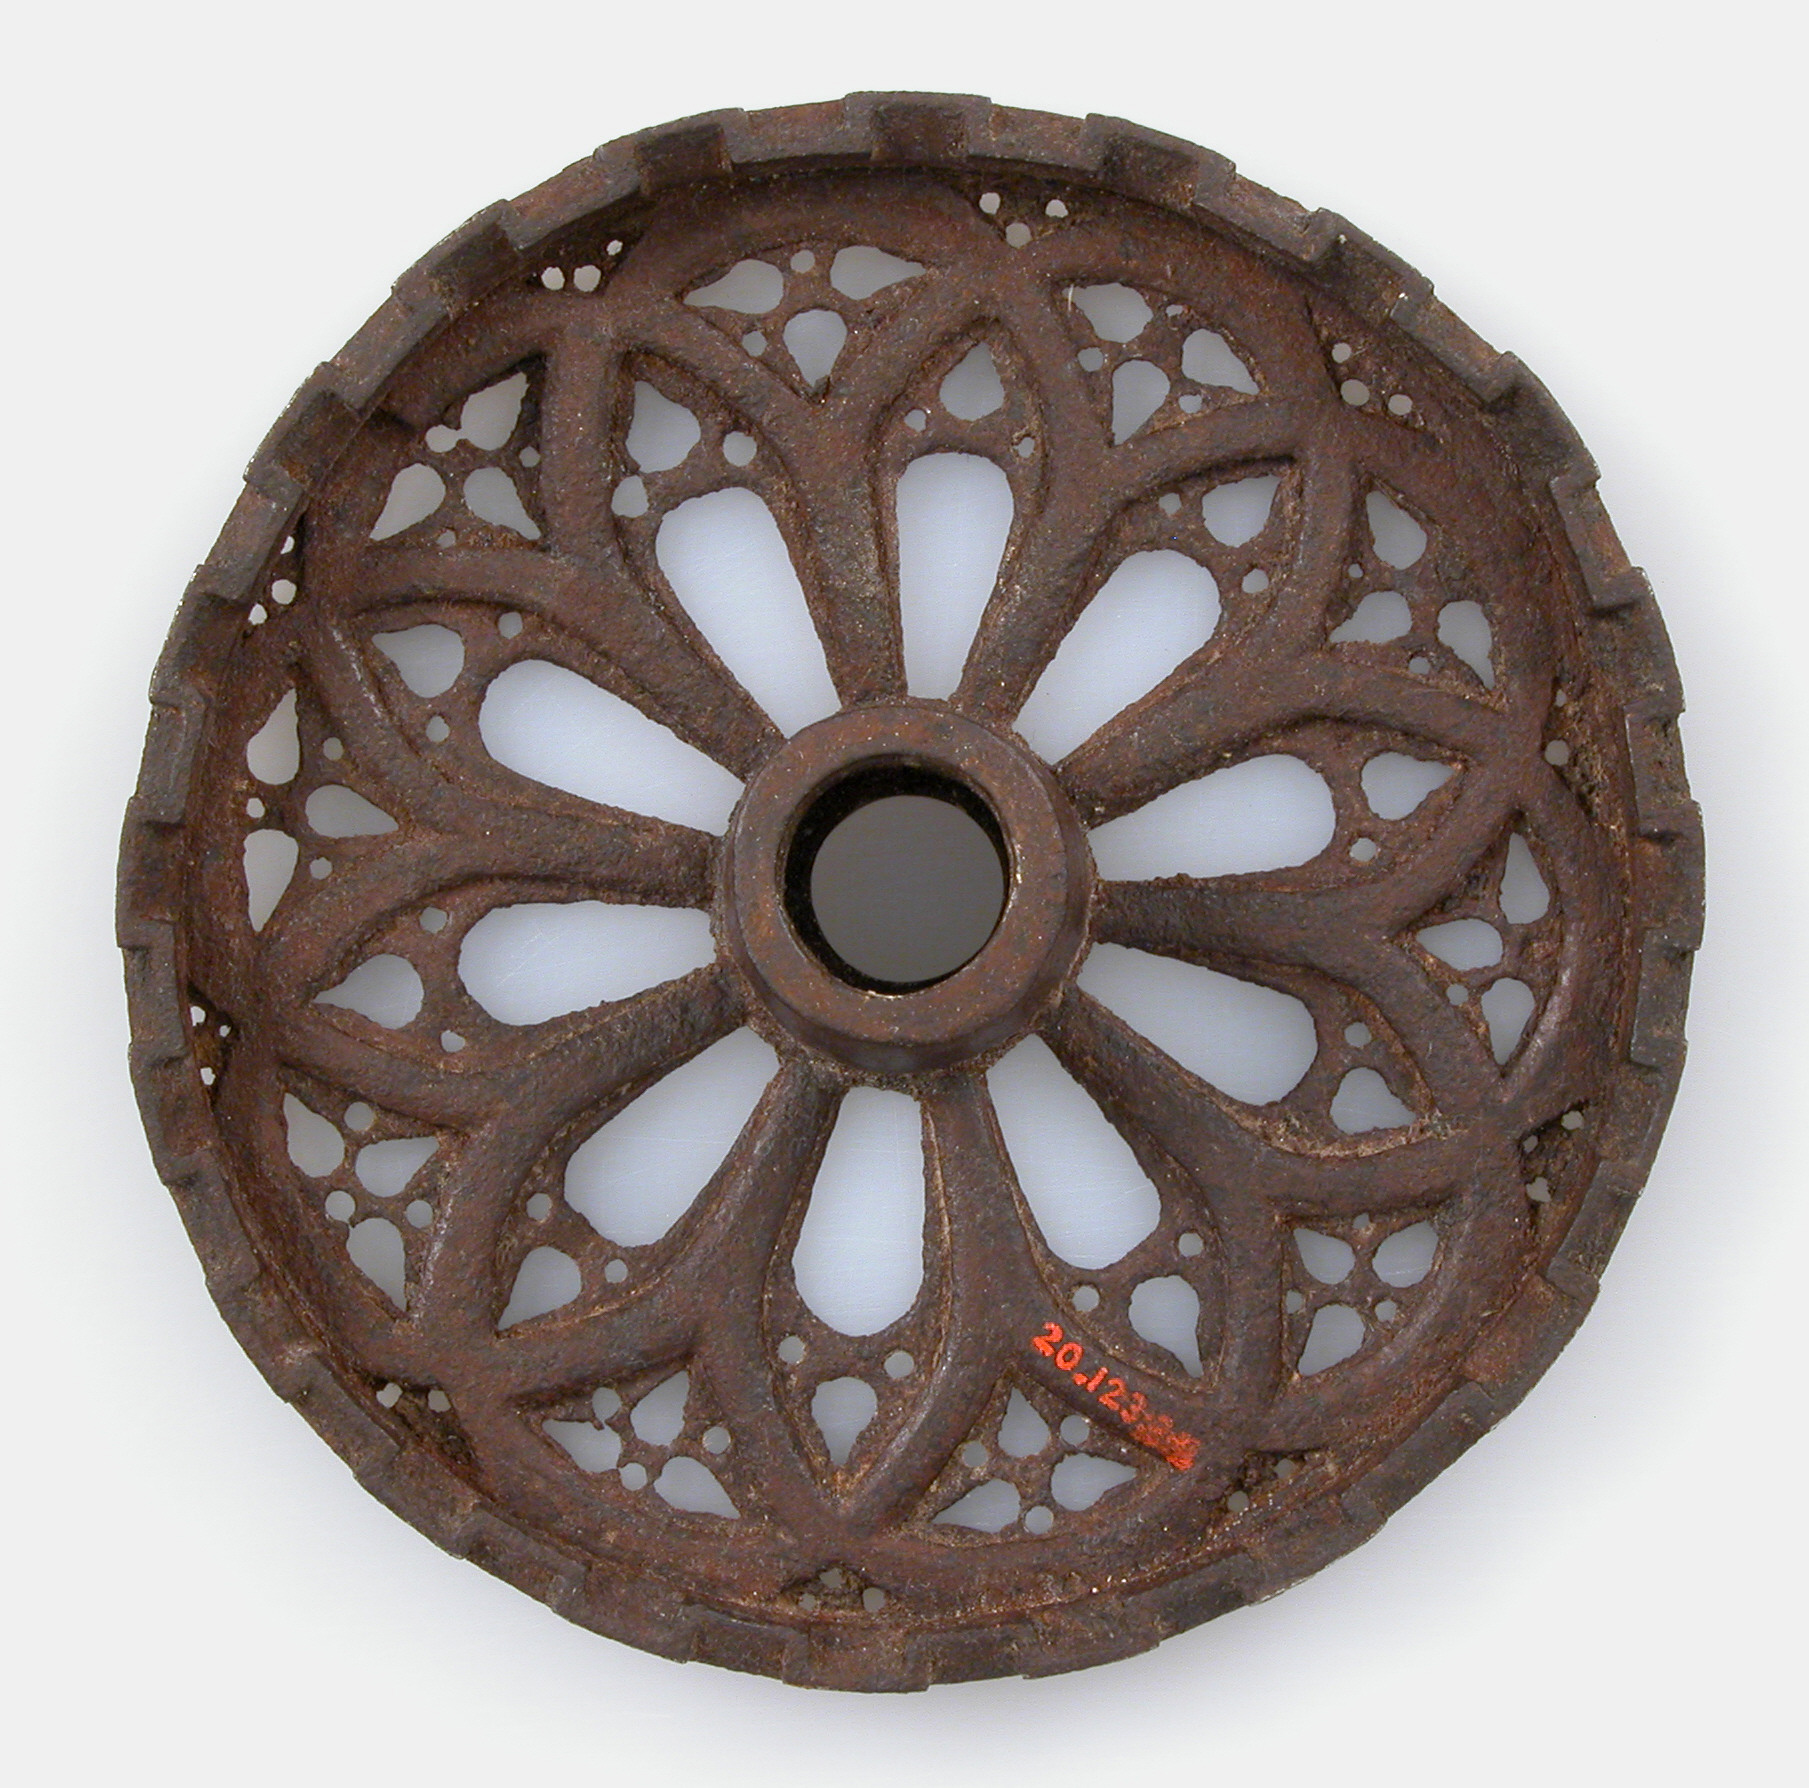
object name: door knocker plate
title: Door Knocker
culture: spanish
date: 1567-1600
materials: iron